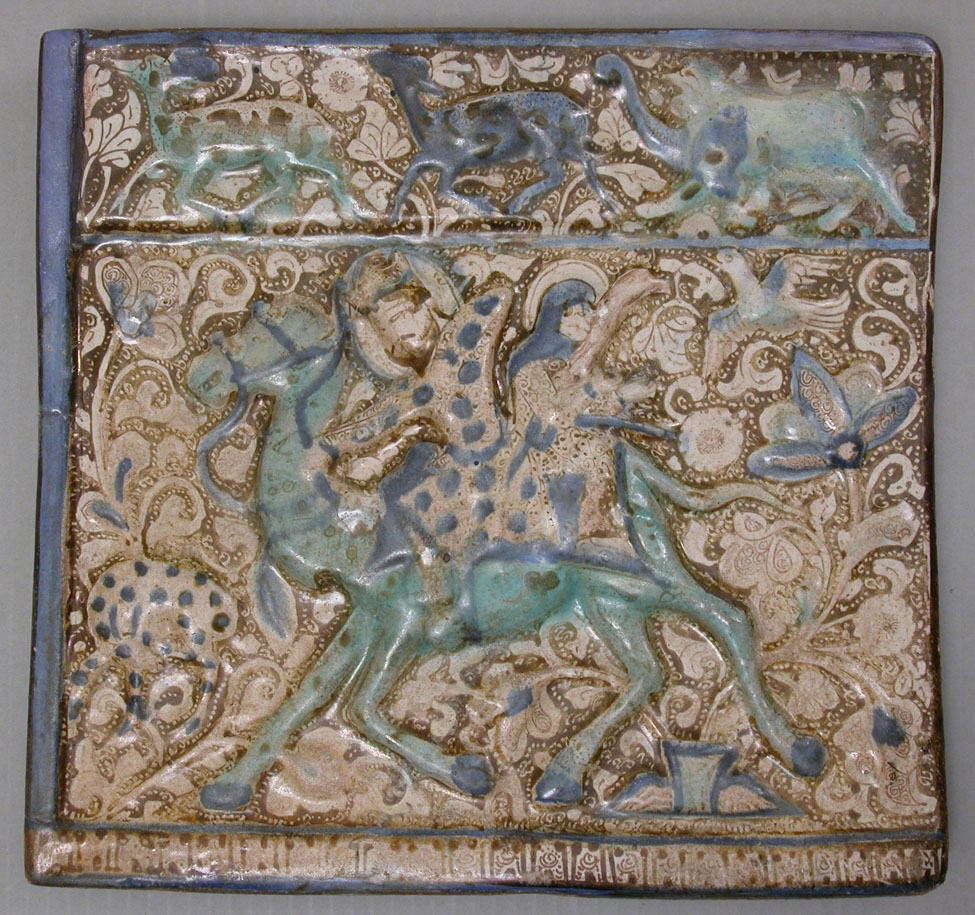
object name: tile from a frieze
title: Tile Depicting Bahram Gur and Azada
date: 1300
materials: glaze, stonepaste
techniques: luster painting, painting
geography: iran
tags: birds,kings,deer,horses